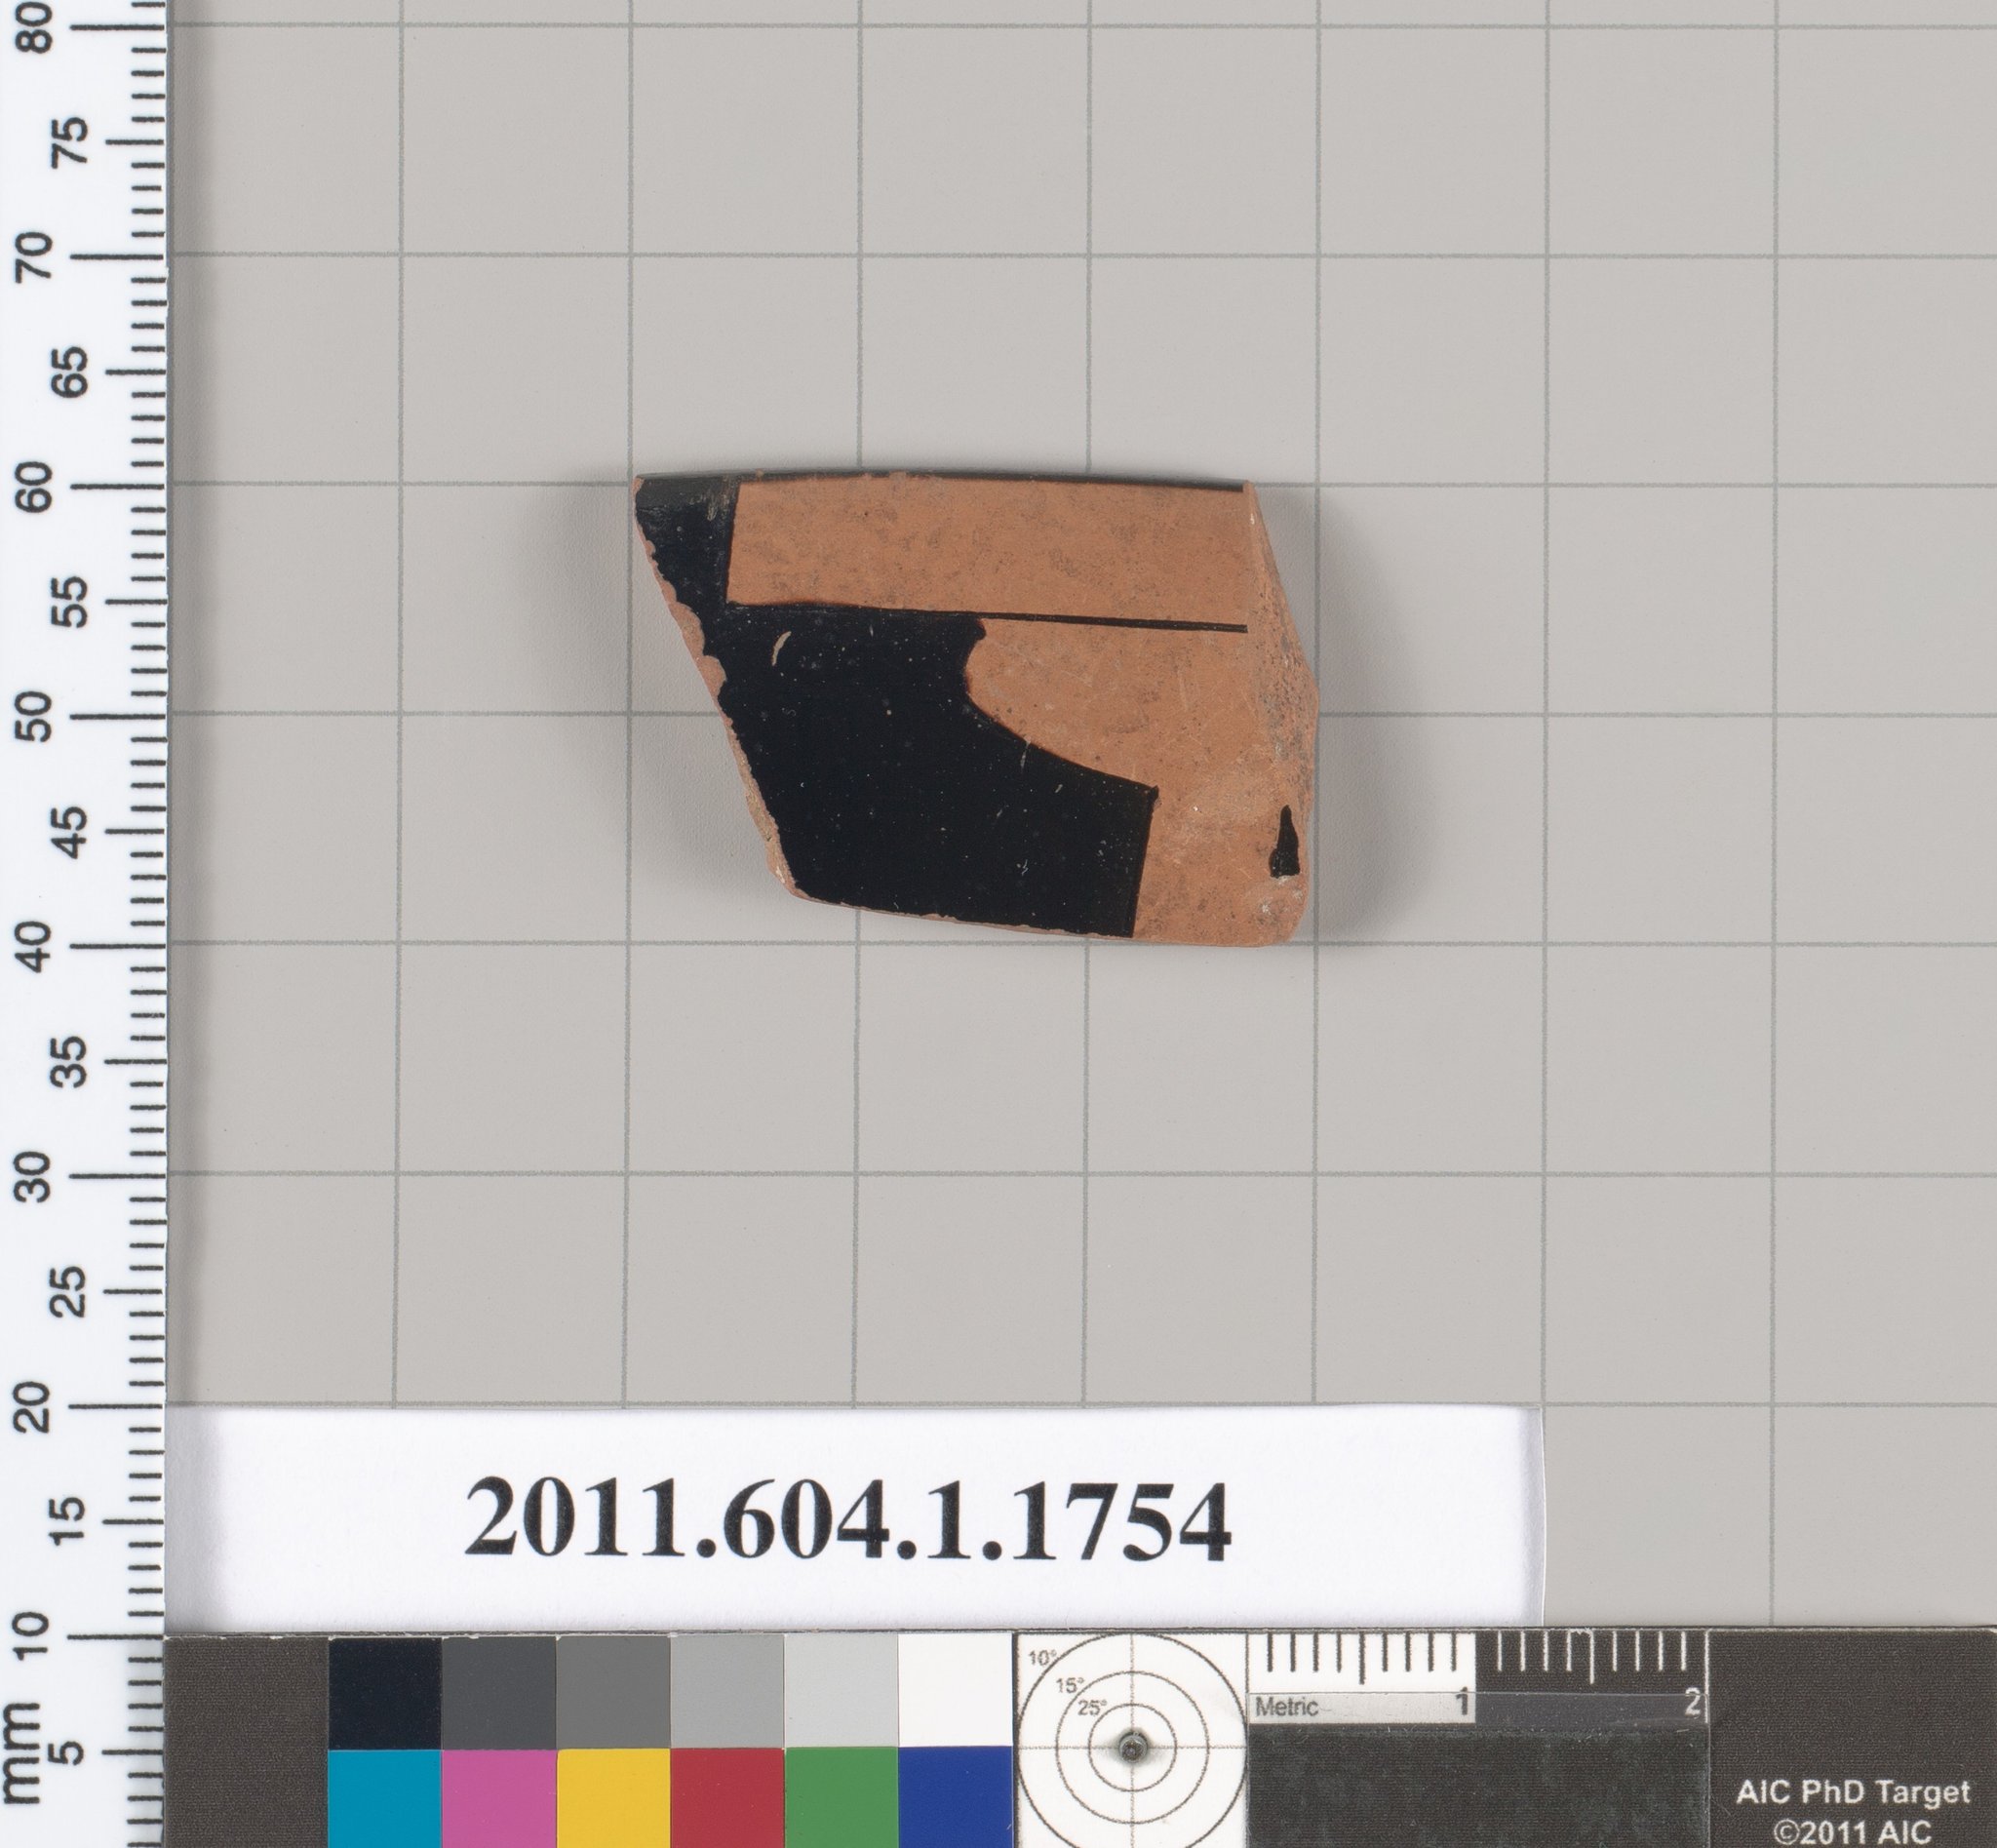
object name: kylix fragment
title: Terracotta rim fragment of a kylix (drinking cup)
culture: greek, attic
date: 475-451 BCE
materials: terracotta